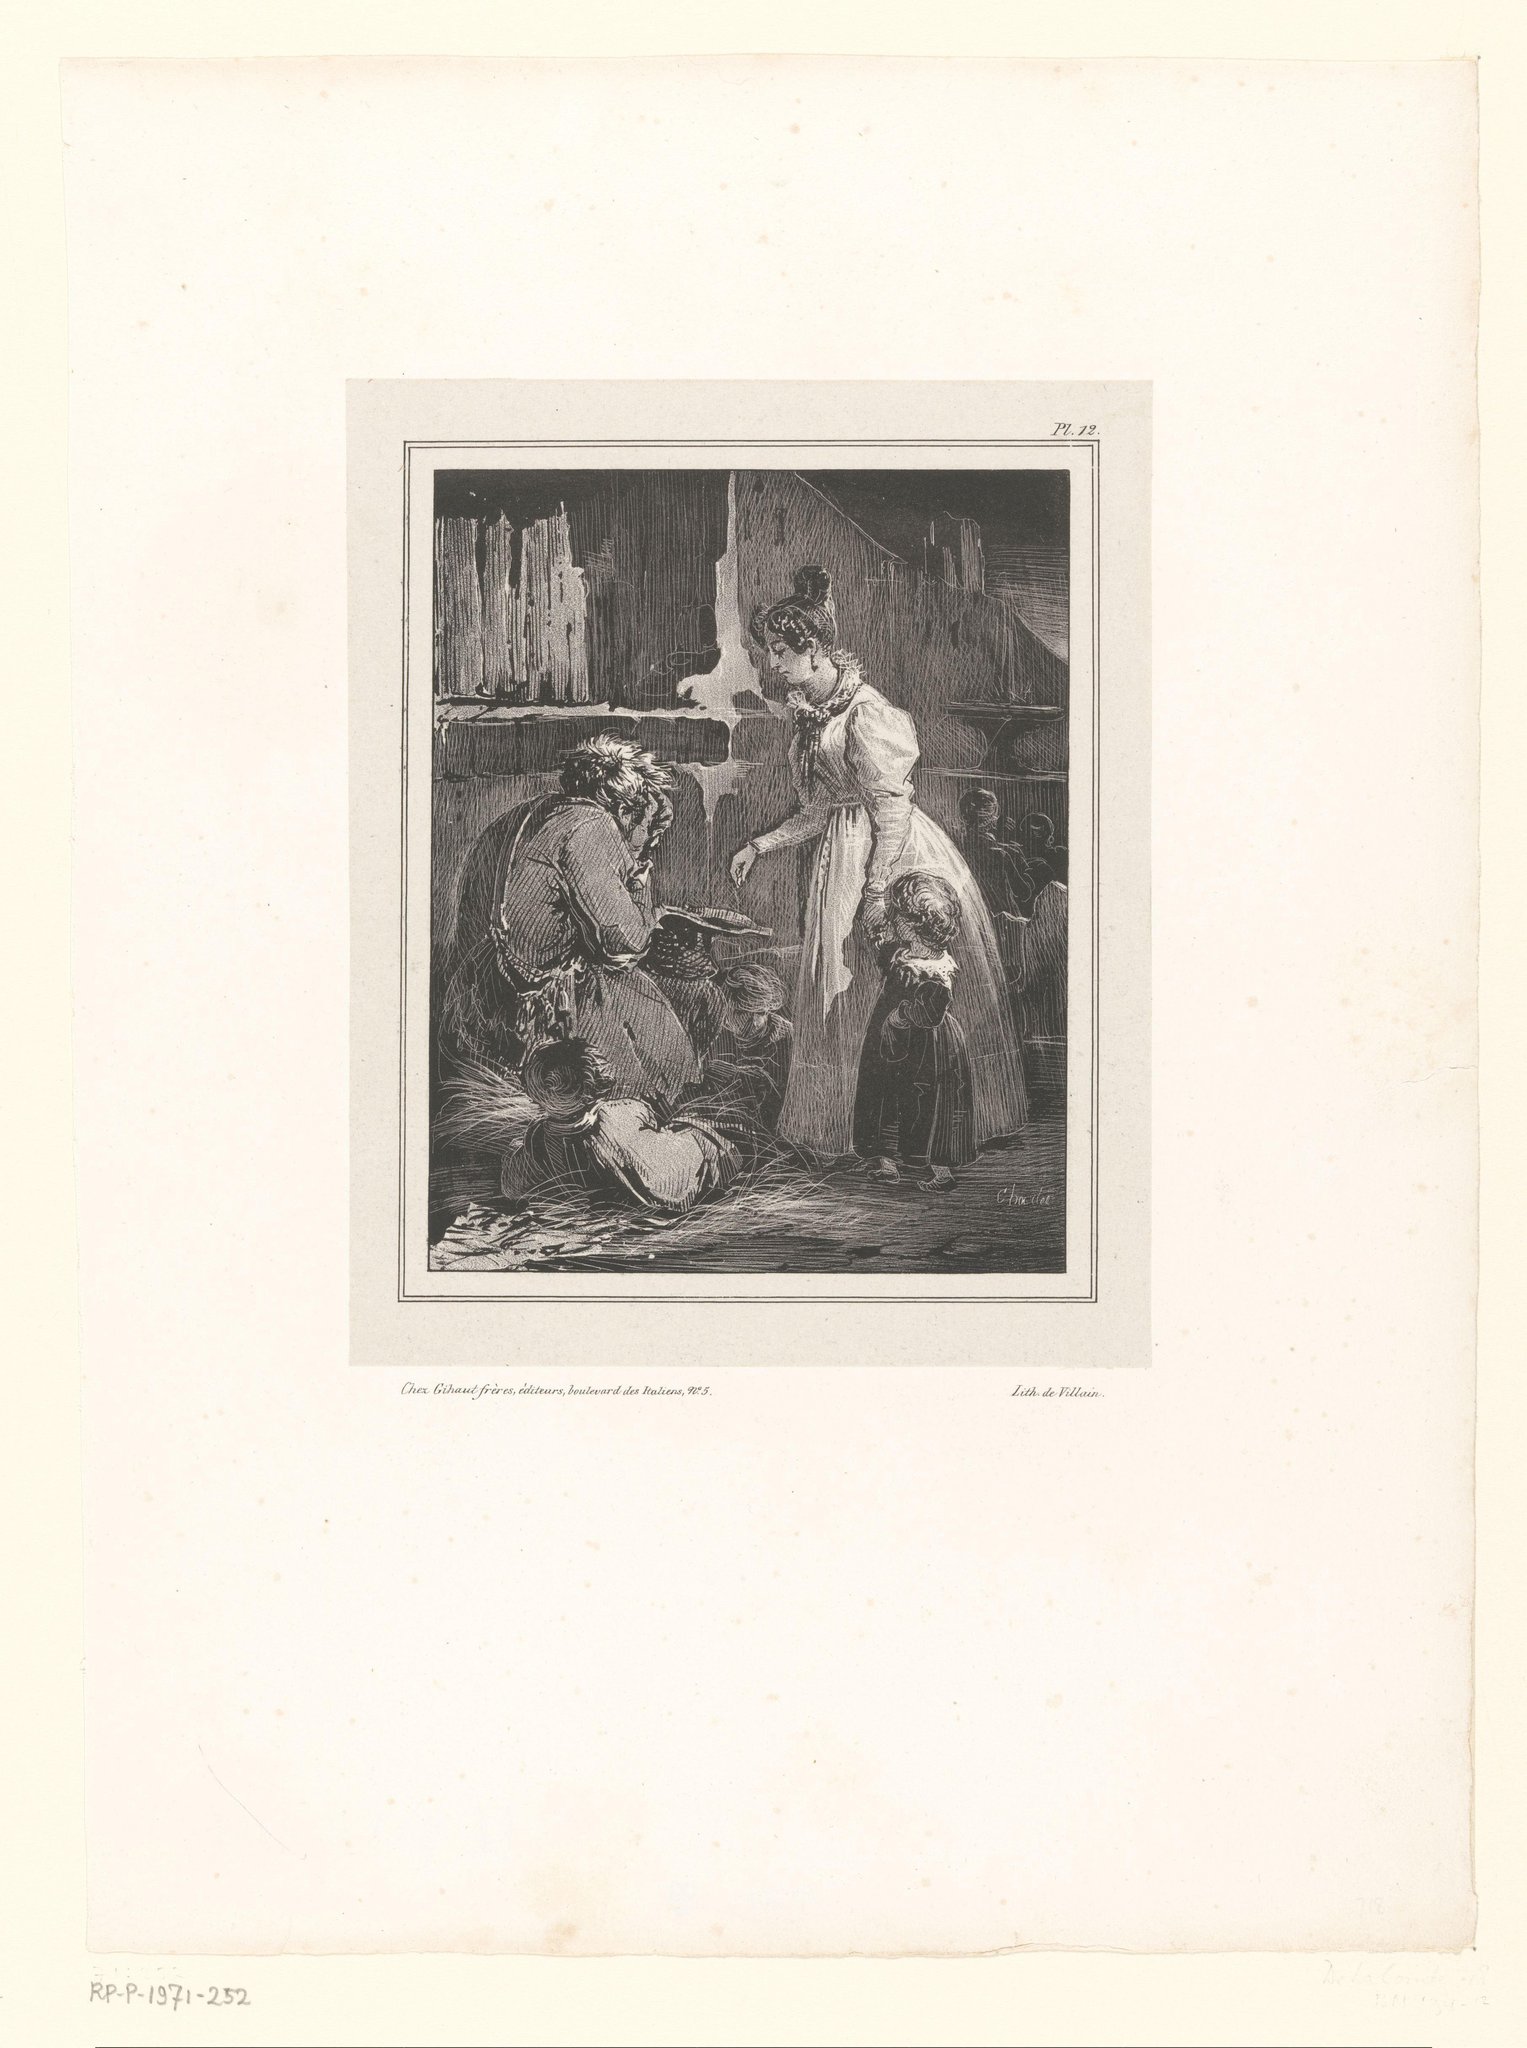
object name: print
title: Croquis et pochades à l'encre par Charlet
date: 1828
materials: paper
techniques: lithograph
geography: paris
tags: giving alms or other charity, e.g.: handing out food, mother and baby or young child, the poor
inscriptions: collector's mark: Lugt 2228a, collector's mark: Lugt 2760